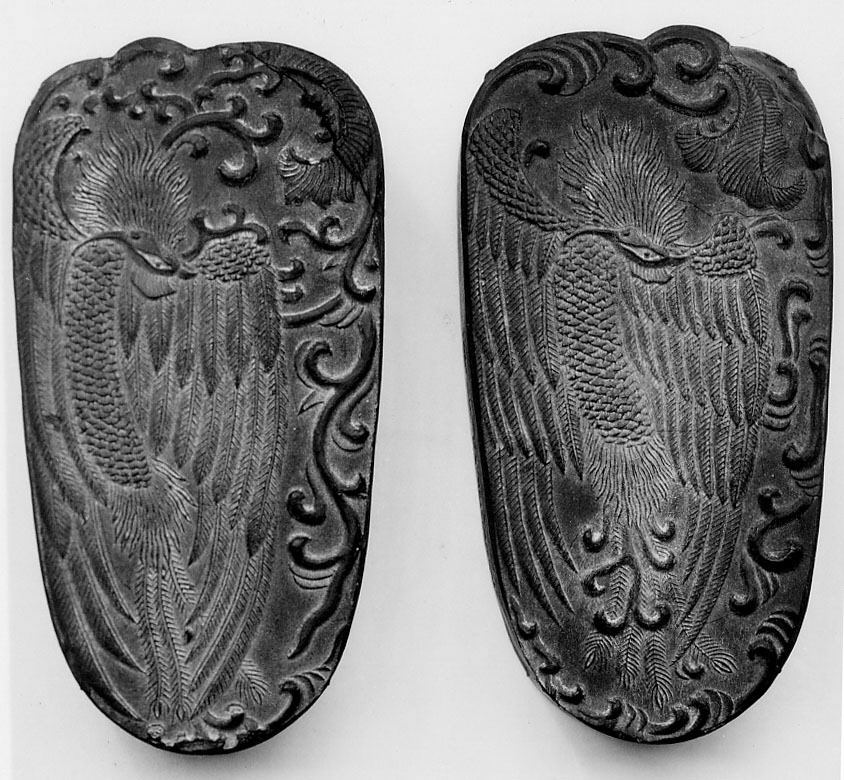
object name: ink tablet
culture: chinese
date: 1867-1933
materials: ink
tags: phoenix